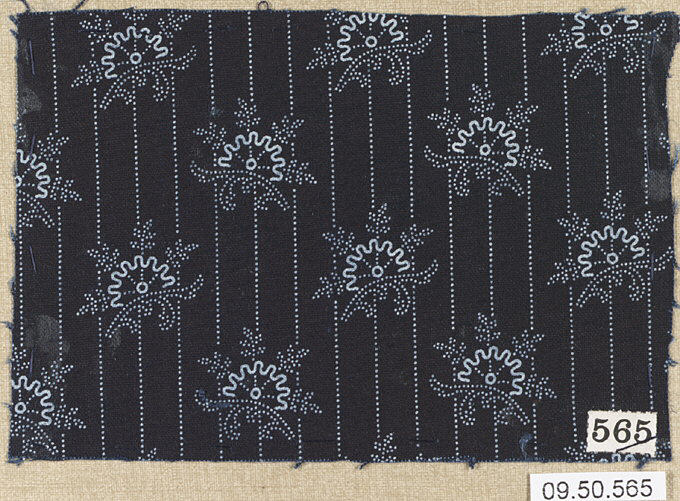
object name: piece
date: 1801-1900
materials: cotton